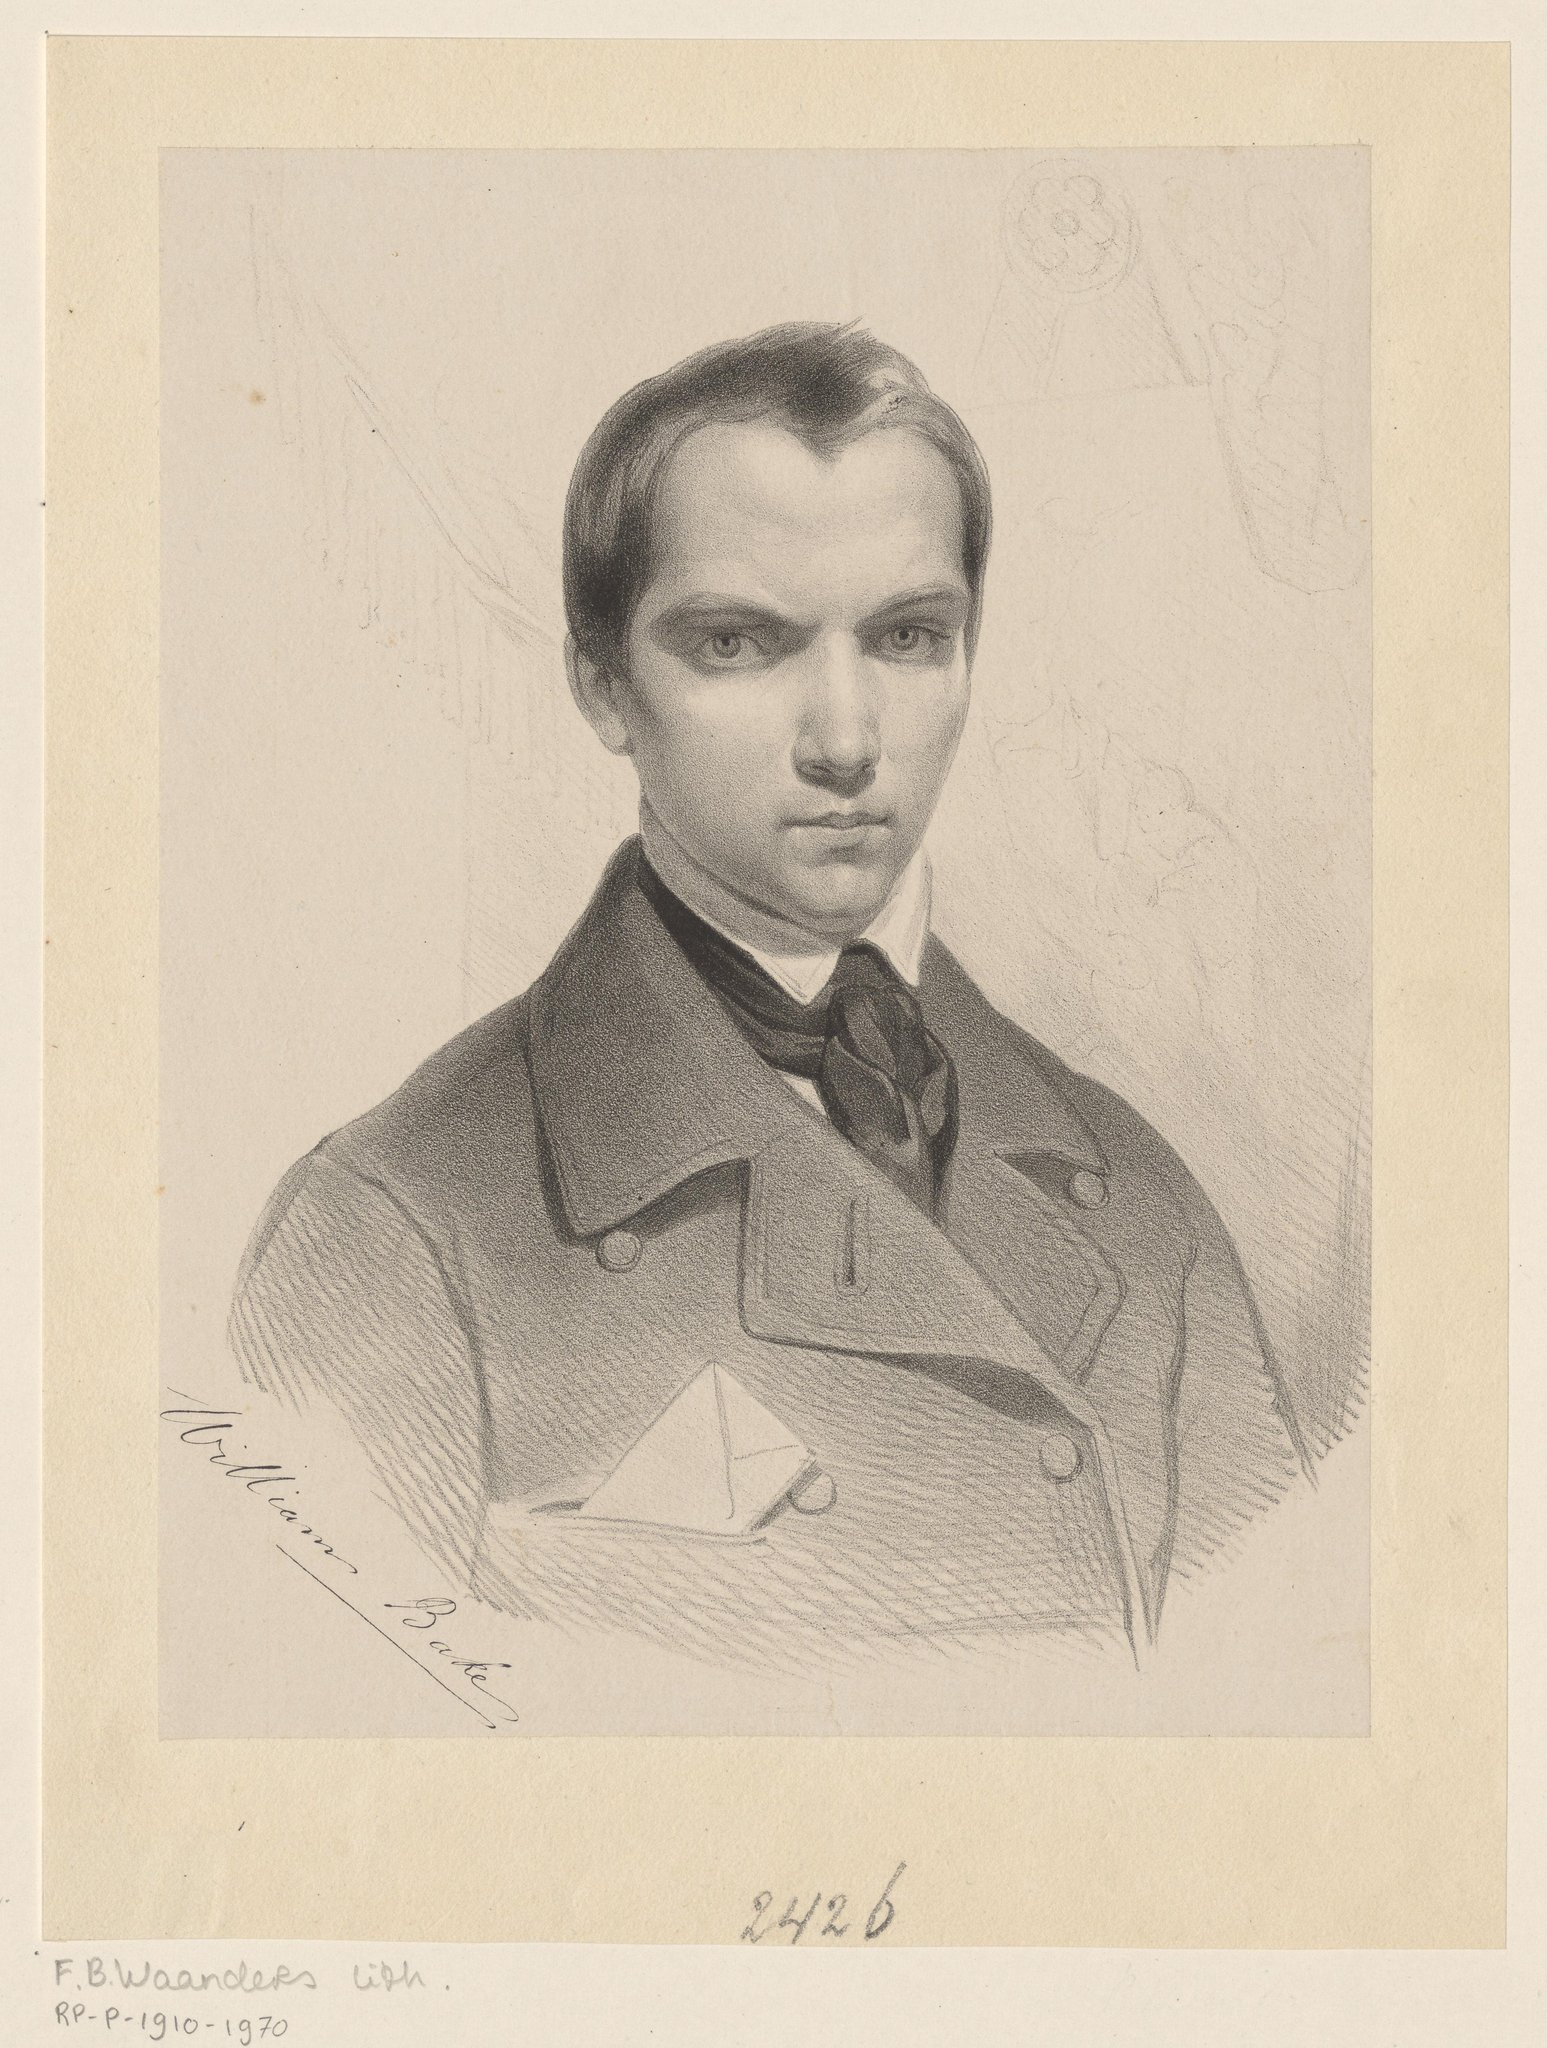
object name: print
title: Portret van William Bake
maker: franciscus bernardus waanders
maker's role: print maker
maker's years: 1809-1880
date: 1847-1865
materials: paper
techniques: lithograph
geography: the hague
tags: historical persons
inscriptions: collector's mark: Lugt 2228